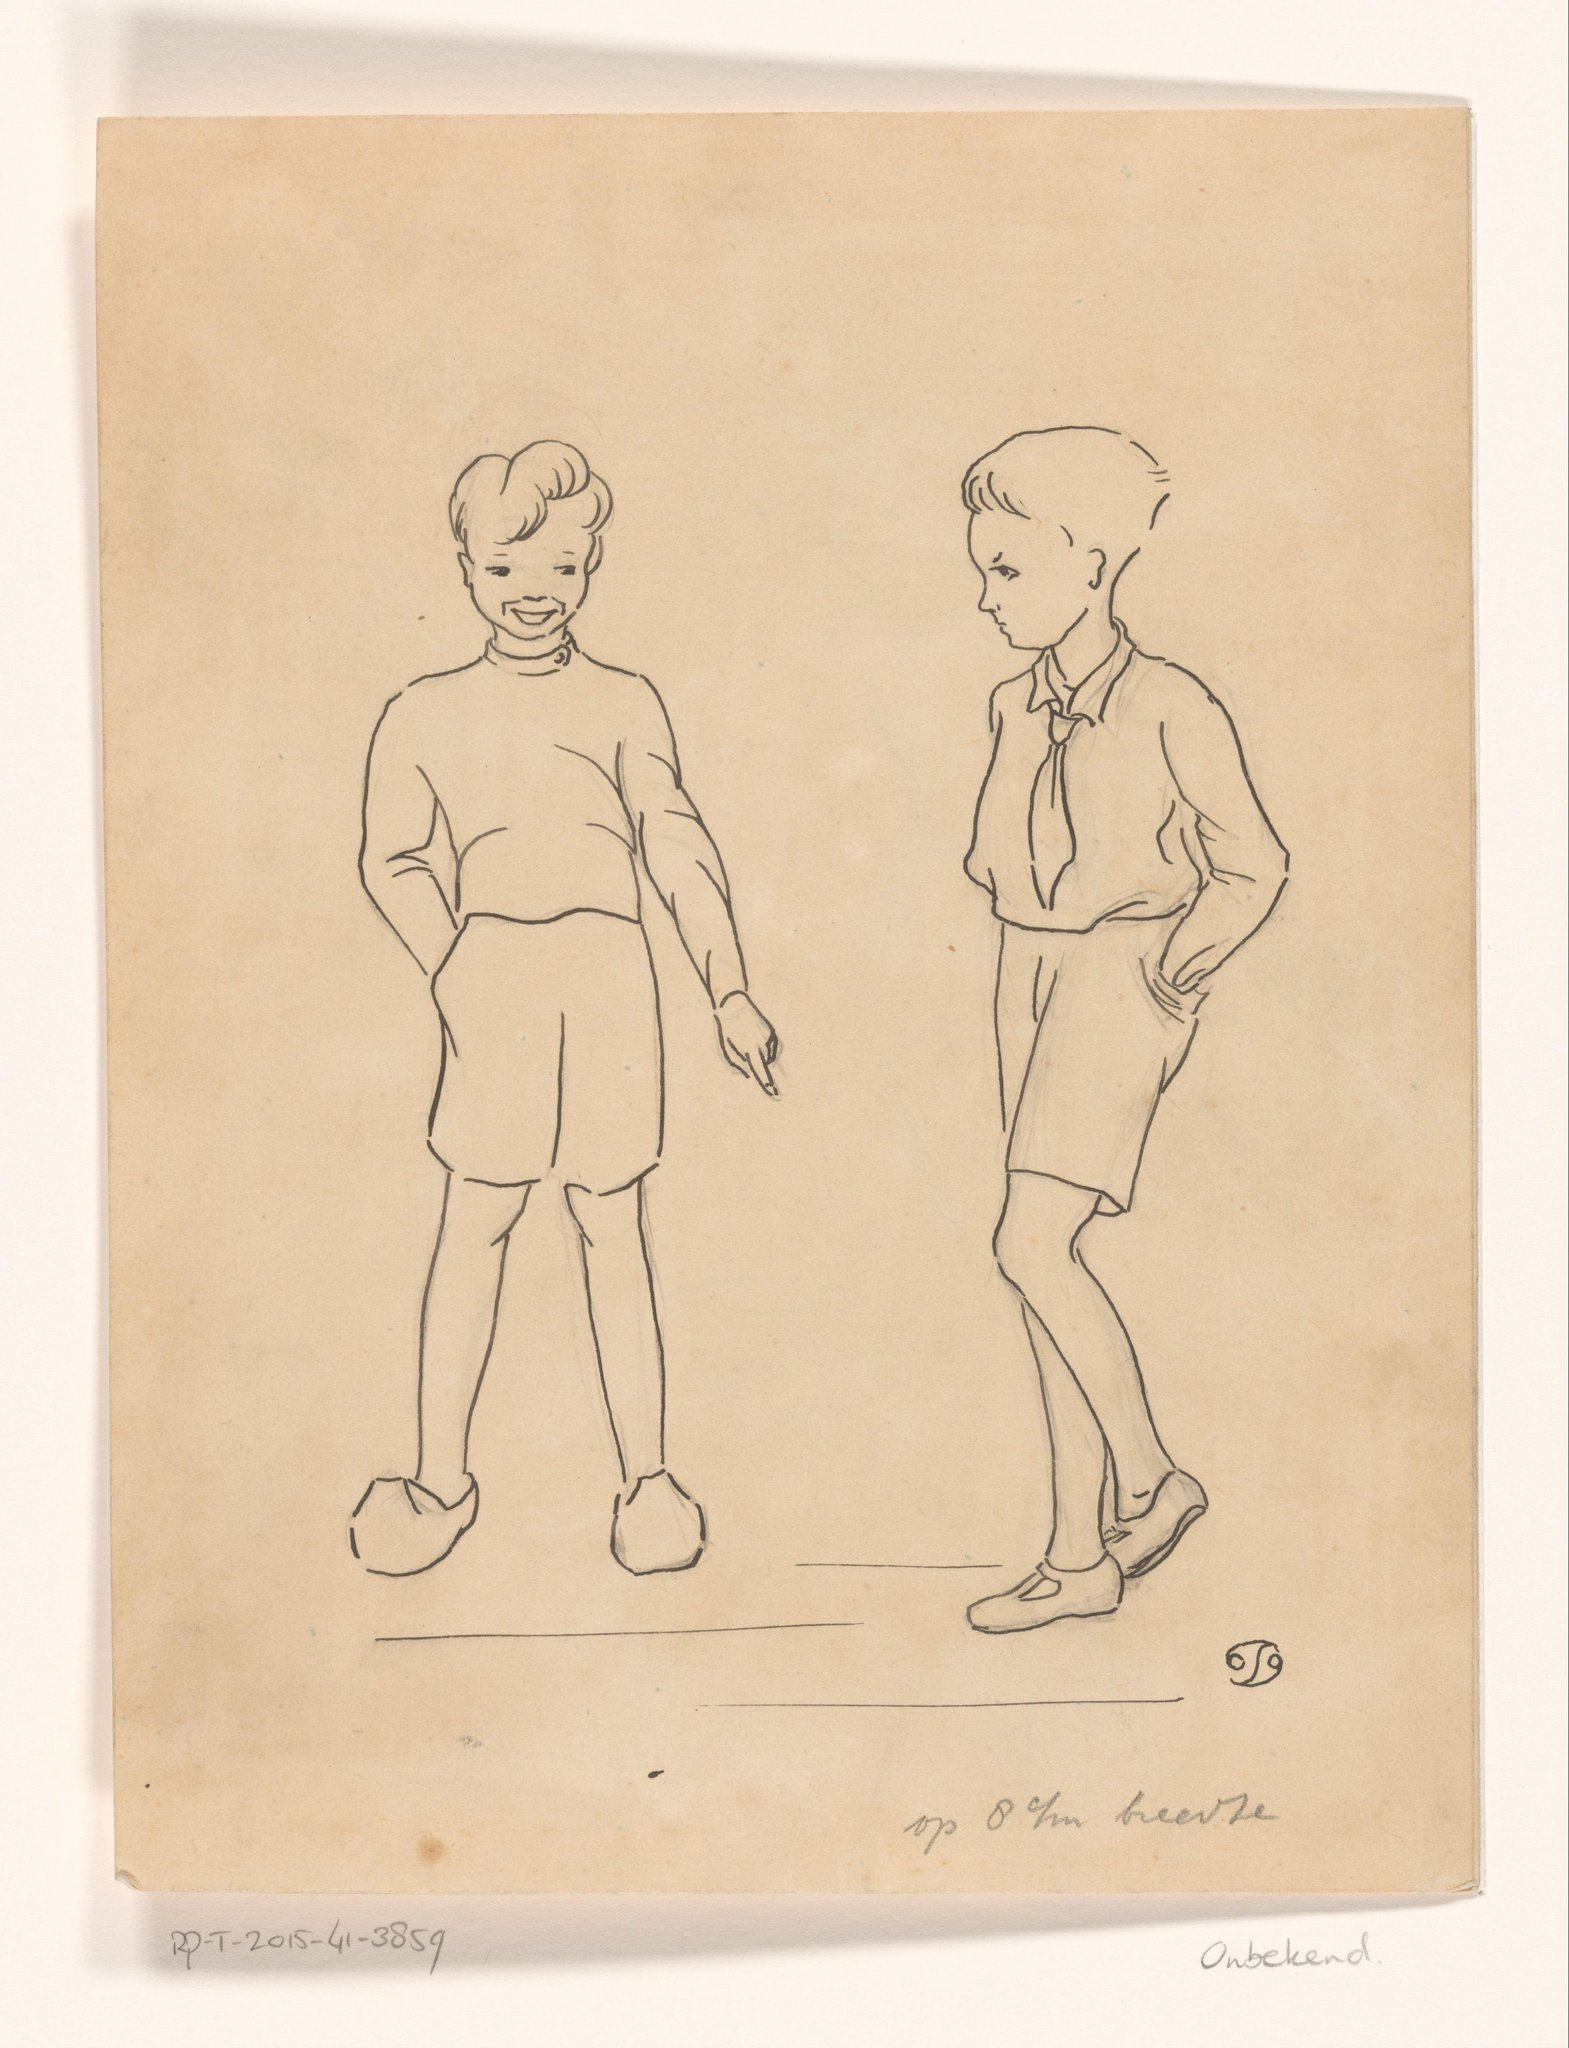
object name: drawing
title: Hans en Hansje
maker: Anonymous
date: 1890-1940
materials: ink, paper, pencil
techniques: pen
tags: hand in the pocket - aa - both arms or hands, wooden shoes, clogs, mocking, insulting; teasing, shoes, sandals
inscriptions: annotation: ‘Hans en Hansje.’, monogram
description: Hans draagt een trui, korte broek en klompen. Hij wijst lachend op de schoenen van Hansje. Hansje heeft zijn handen in de zakken van zijn korte broek en kijkt Hans nors aan.